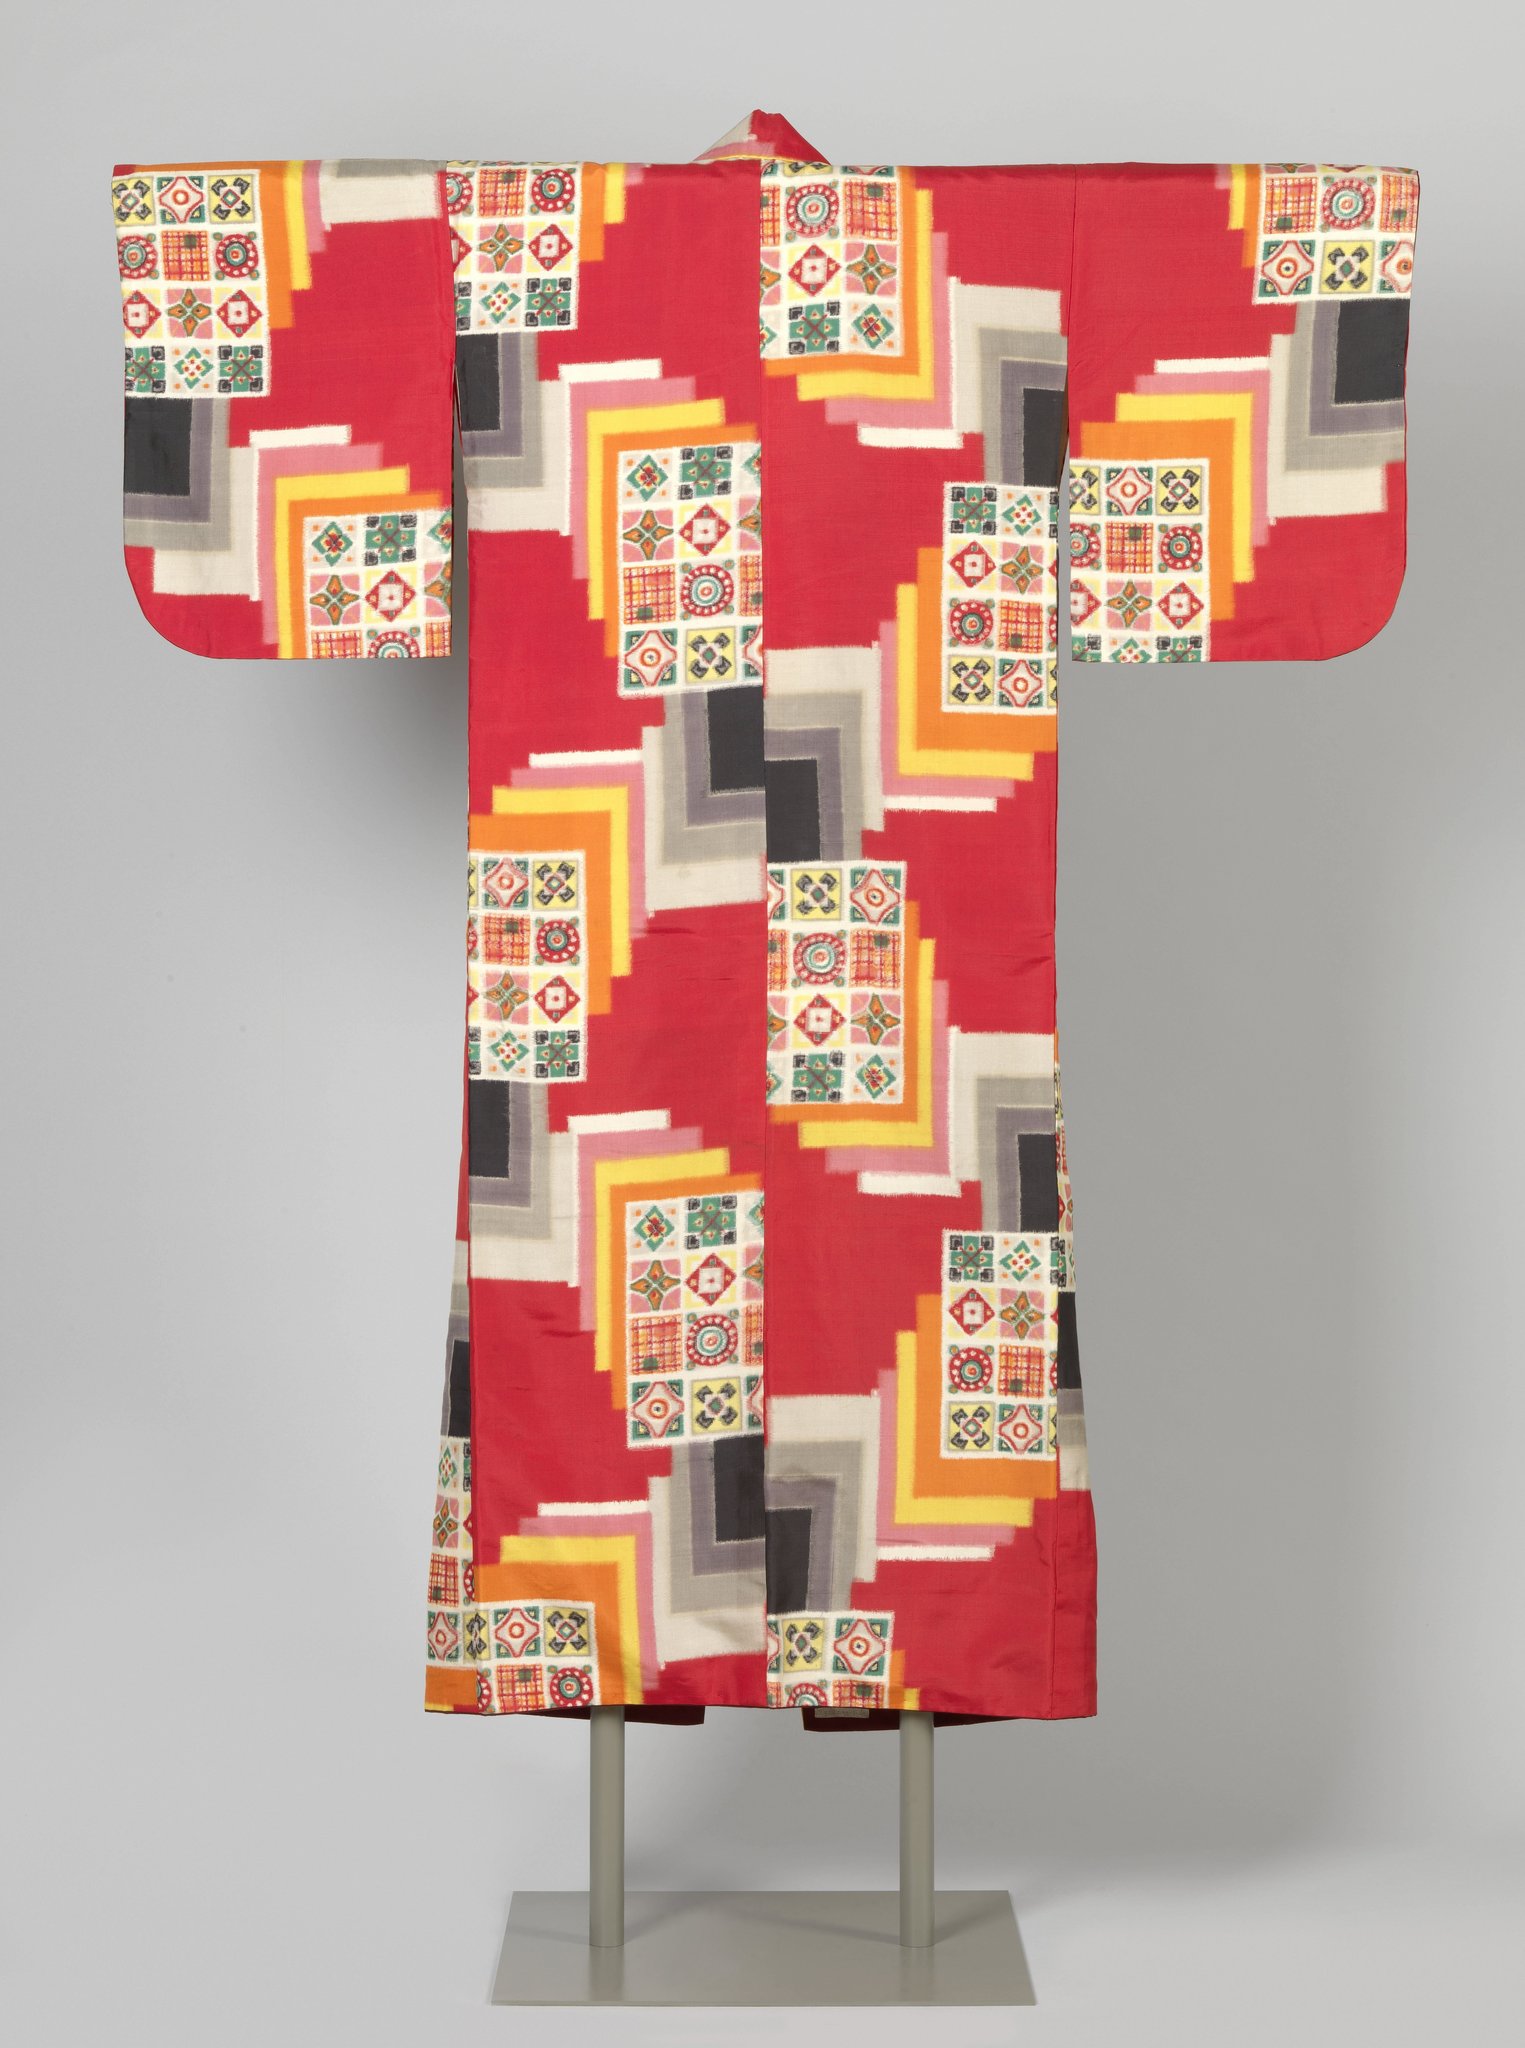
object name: kimono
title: Kimono for an unmarried woman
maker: Anonymous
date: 1920-1940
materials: cotton, silk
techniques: painting, weave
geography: japan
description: This kimono’s decoration of rhythmically distributed blocks would have struck a highly modern chord in the 1920s. Relatively thick, raw silk was used for kimonos for everyday wear, available readymade in the shops. ‘Off the peg’ kimonos were a new phenomenon. Before then, people bought long lengths of fabric, which was cut to size and assembled.